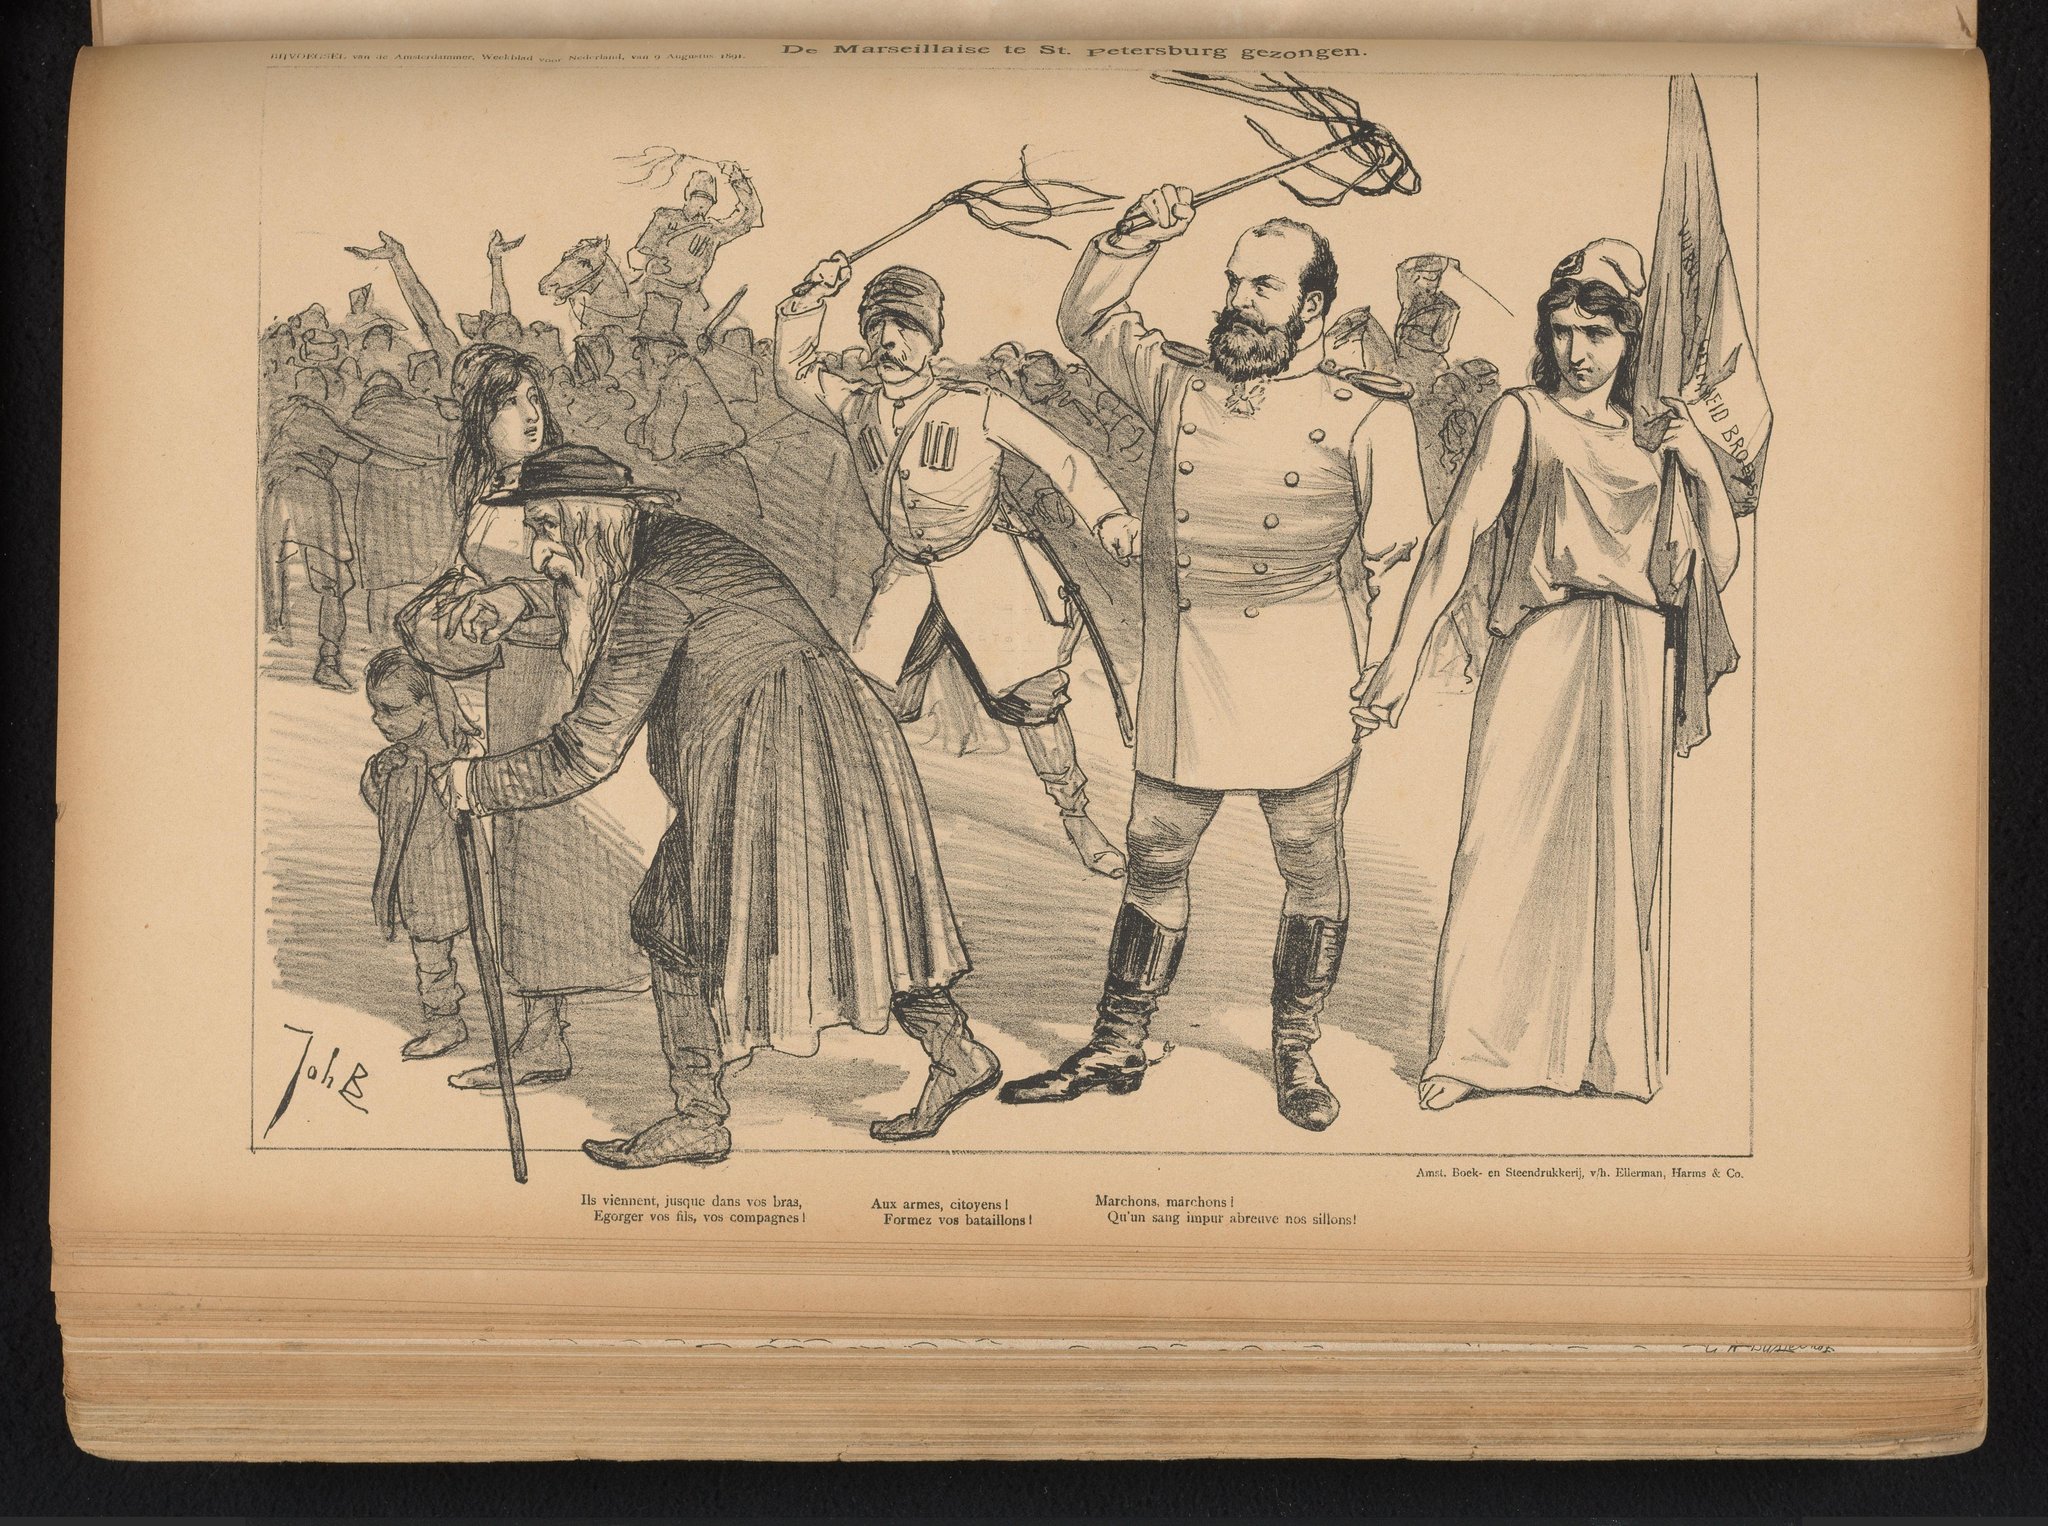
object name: cartoon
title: De Marseillaise te St. Petersburg gezongen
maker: johan braakensiek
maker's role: draughtsman, print maker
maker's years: 1858-1940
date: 1891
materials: paper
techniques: lithograph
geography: amsterdam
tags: instruments of torture, execution or punishment: scourge, personifications of countries, nations, states, districts, etc. (+ nation; national), political caricatures and satires, russia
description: De Russische tsaar Alexander III en zijn legerofficieren geselen het Russische (joodse?) volk. De tsaar staat hand in hand met Marianne (Frankrijk).